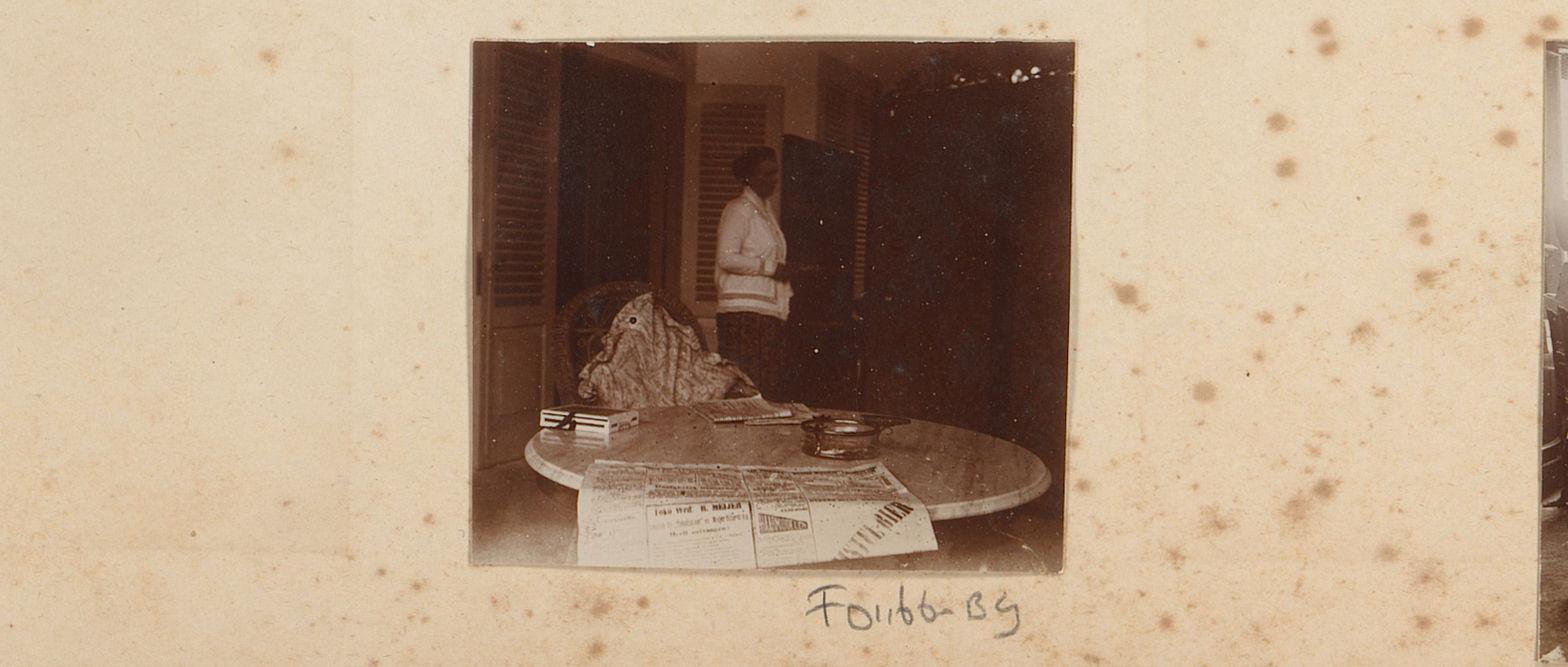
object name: album leaf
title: Nederlandse vrouw bij een tafel met krant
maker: Anonymous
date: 1895-1910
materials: photographic support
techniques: gelatin silver print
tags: adult woman, historical persons, table, newspaper, news-sheet, dutch east indies, the